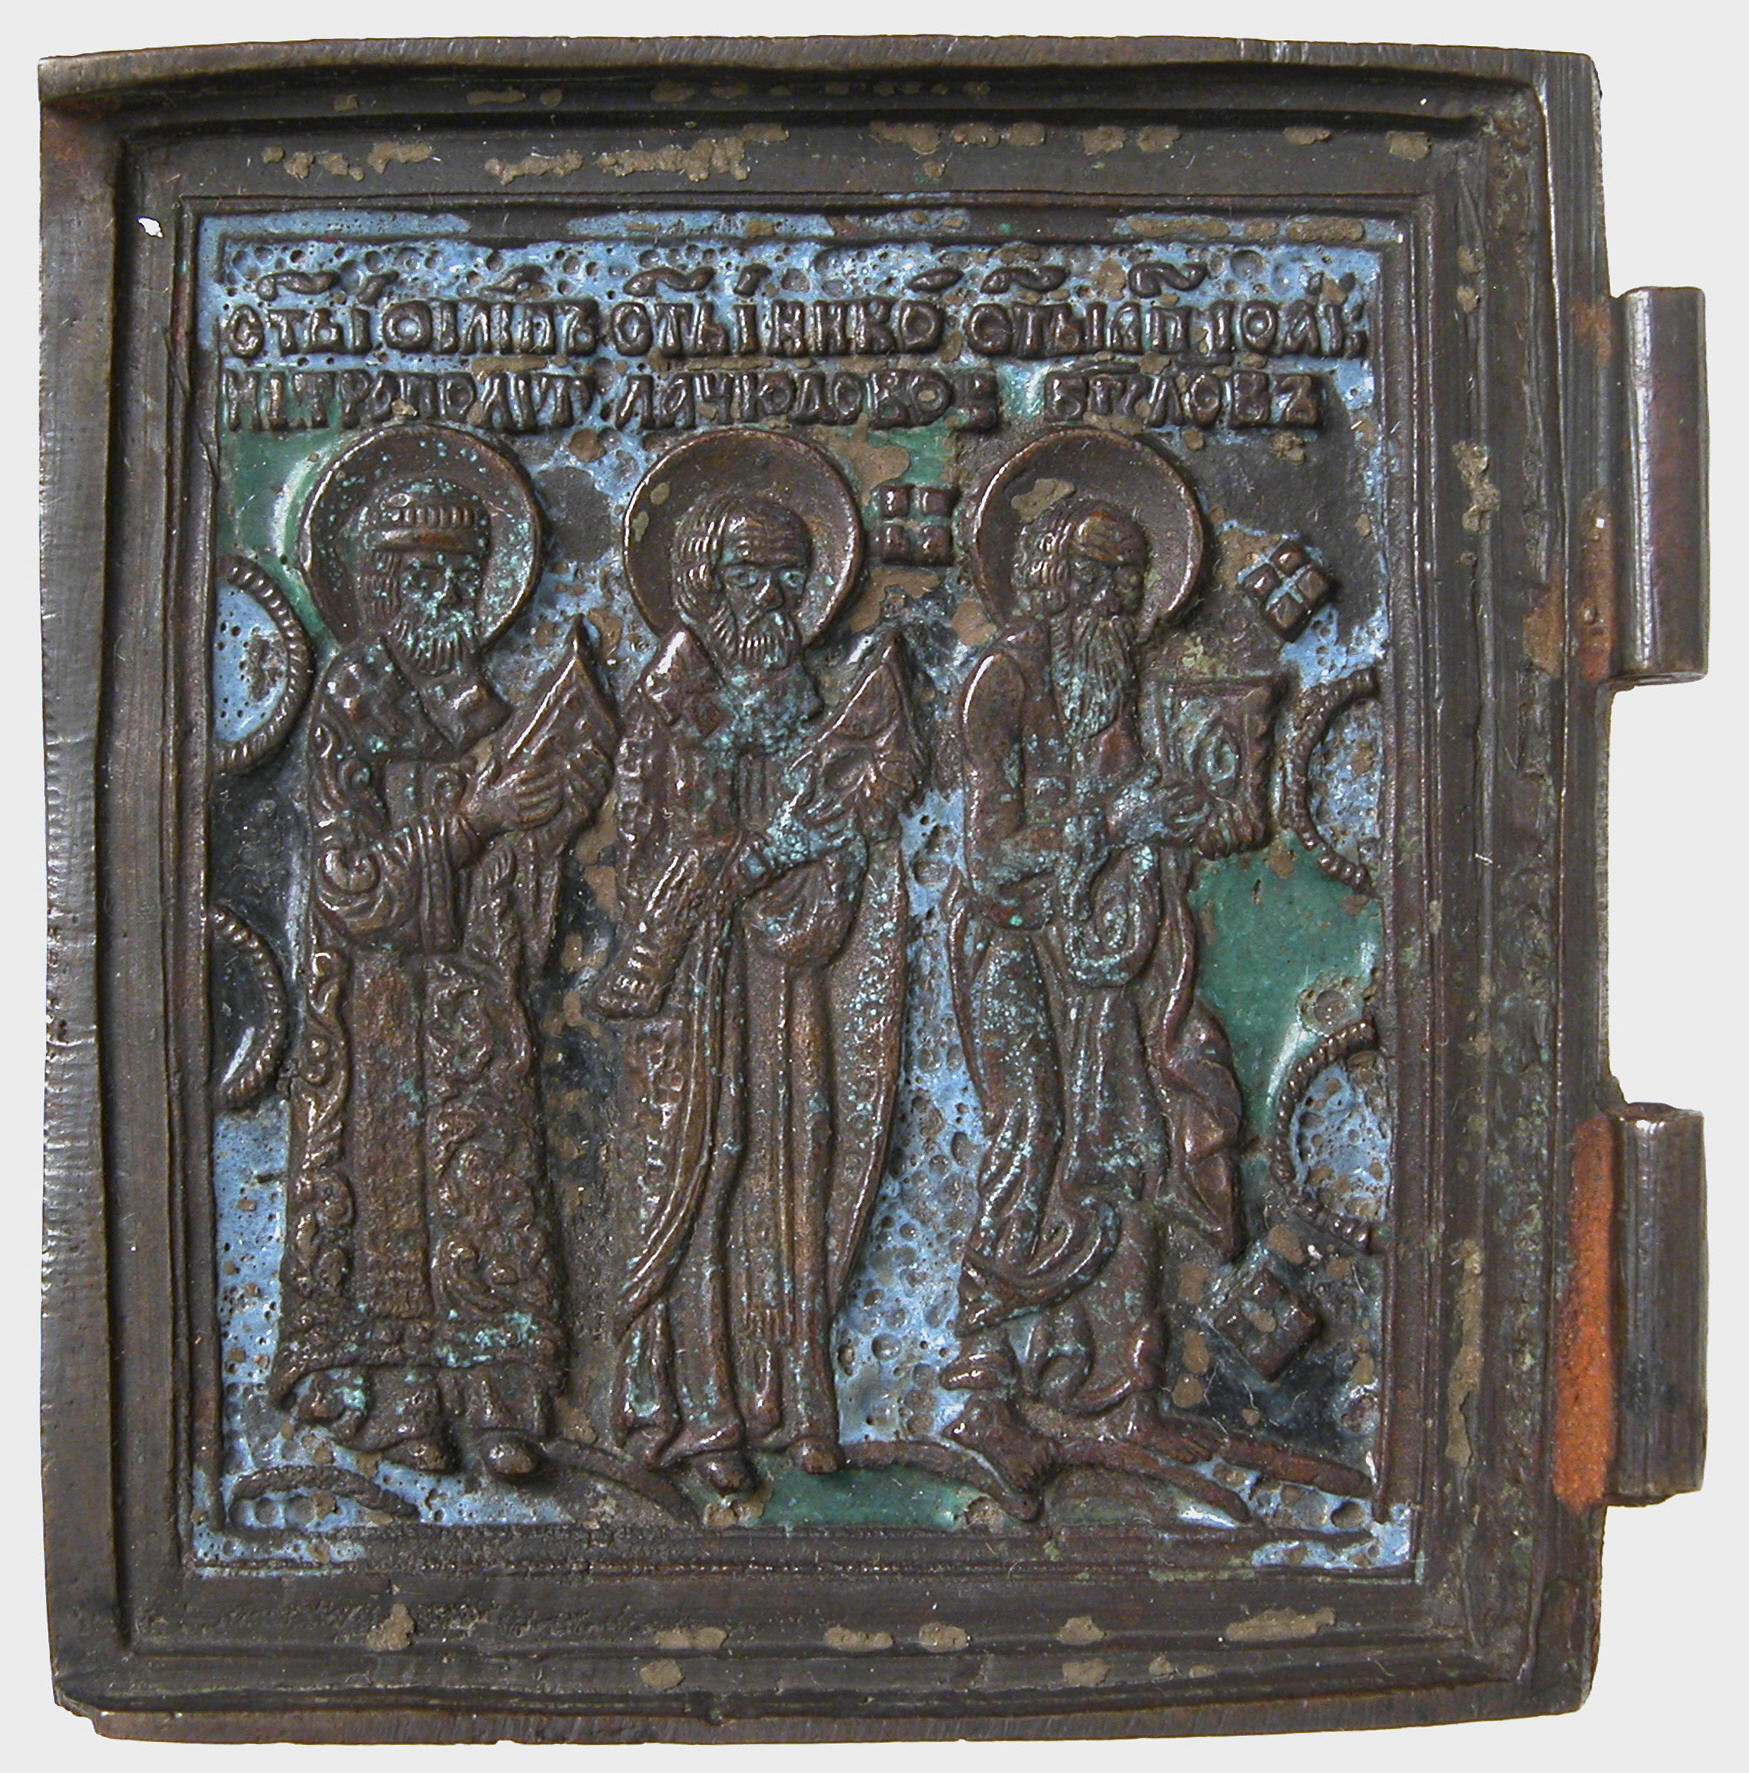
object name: diptych leaf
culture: russian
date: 1701-1900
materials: brass, enamel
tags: men